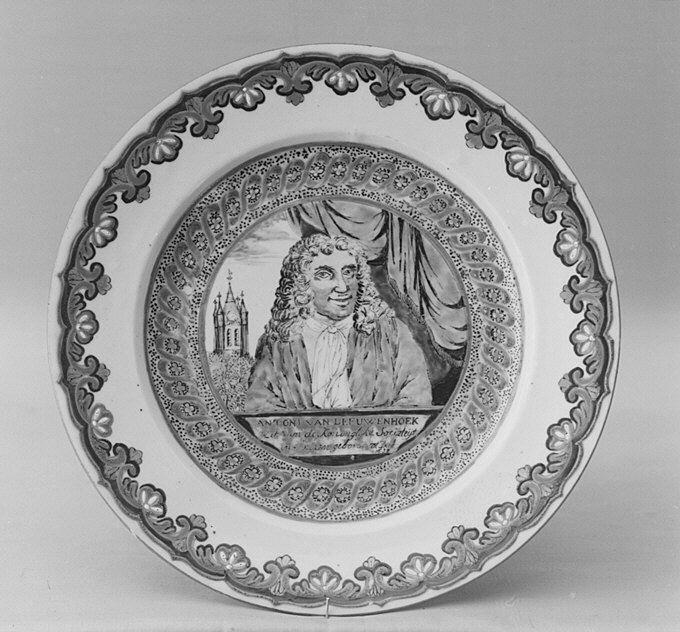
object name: plate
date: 1774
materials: hard paste porcelain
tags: men,portraits